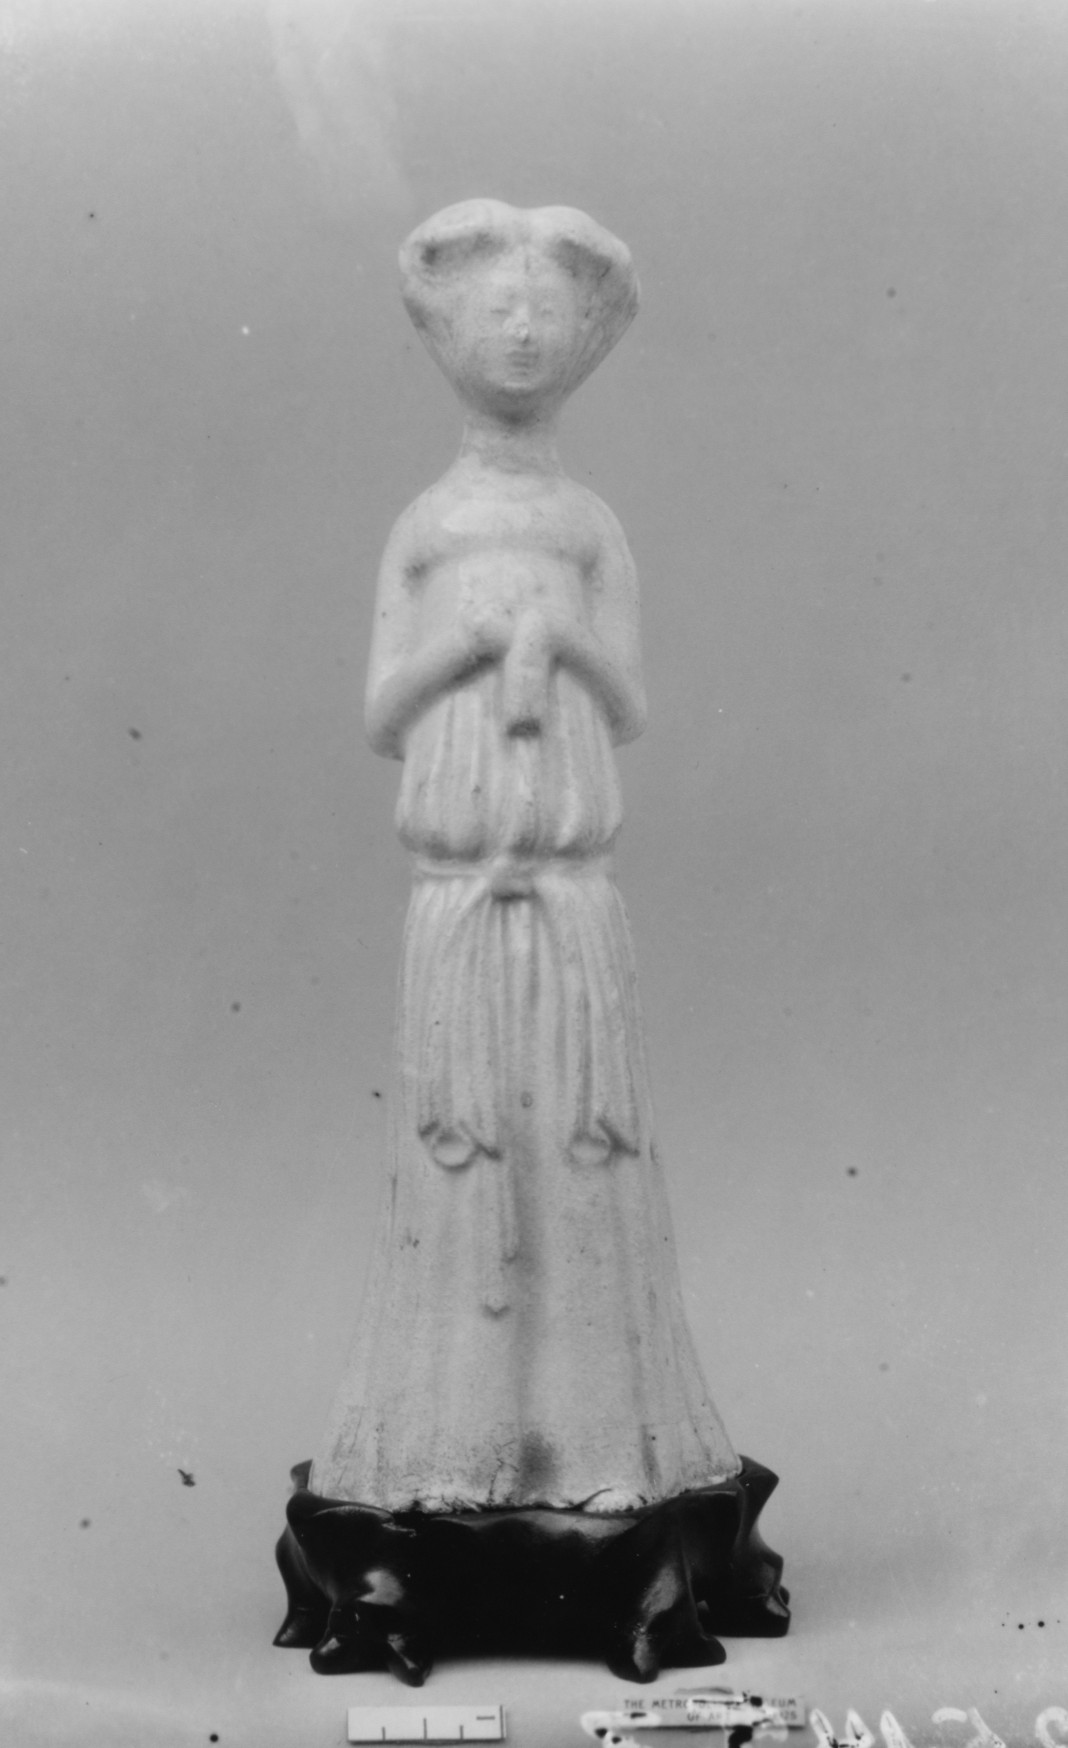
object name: figure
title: Female attendant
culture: chinese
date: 601-700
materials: earthenware, glaze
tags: women